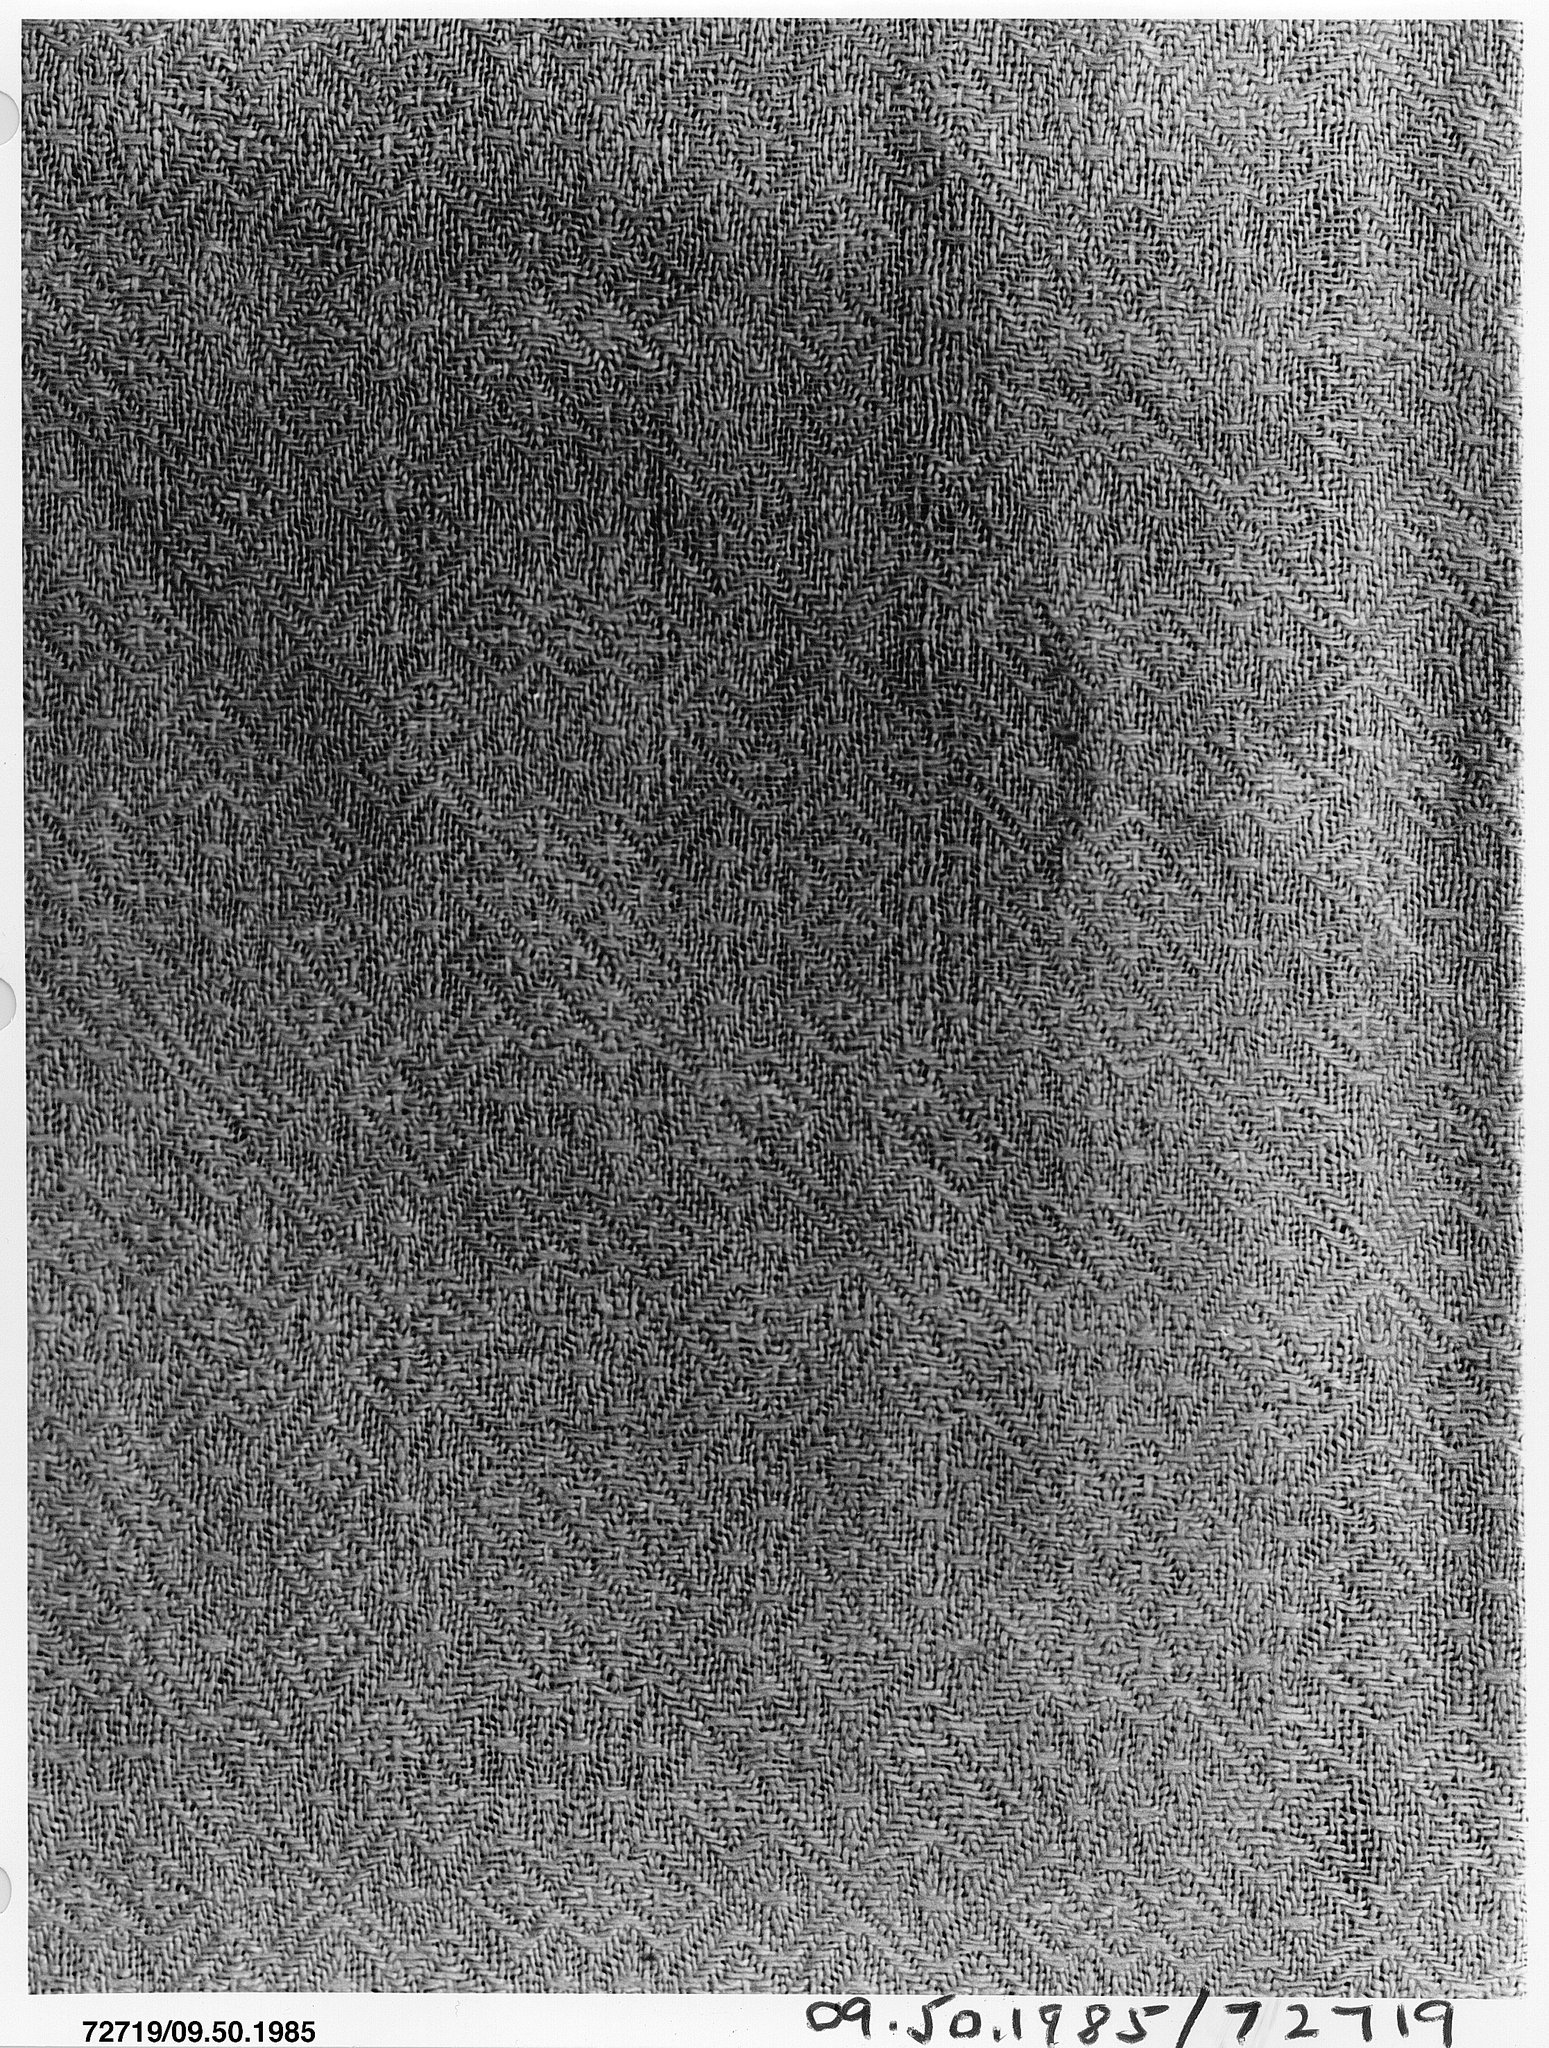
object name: piece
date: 1701-1900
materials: linen